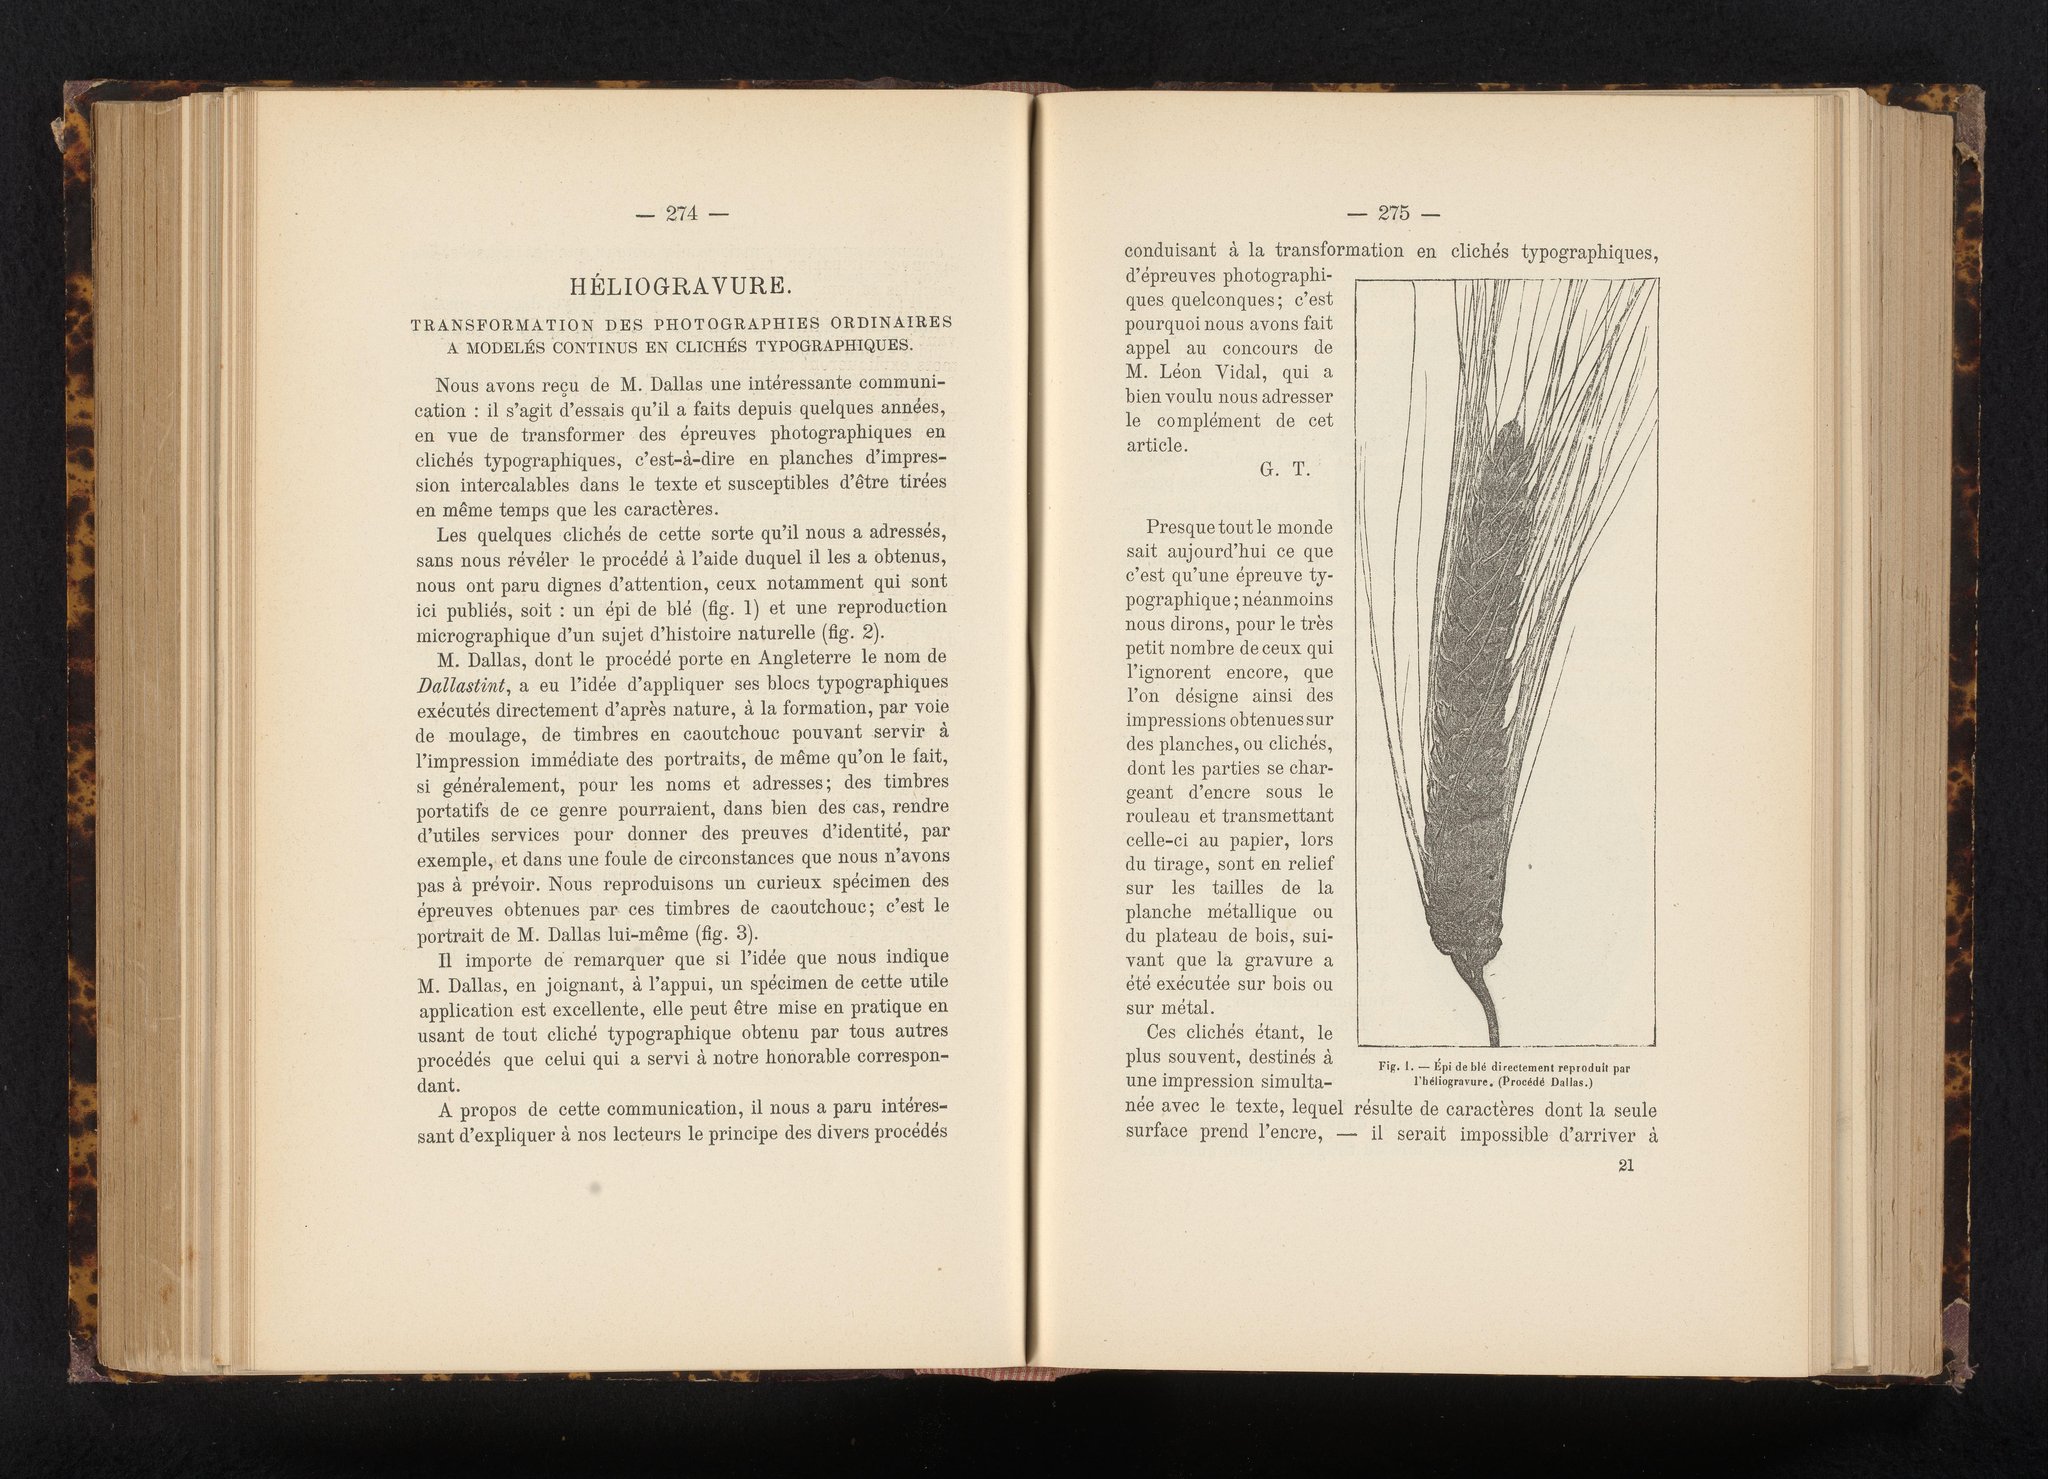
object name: photomechanical print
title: Épi de blé directement reproduit par l'héliogravure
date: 1881-1886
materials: paper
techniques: photolithography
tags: cereal, grain, corn (grass with grains, grown for food, e.g.: wheat, rice, rye, oats, maize, buckwheat, millet)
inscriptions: inscription: ‘Fig. 1. (...) (Procédé Dallas.)’